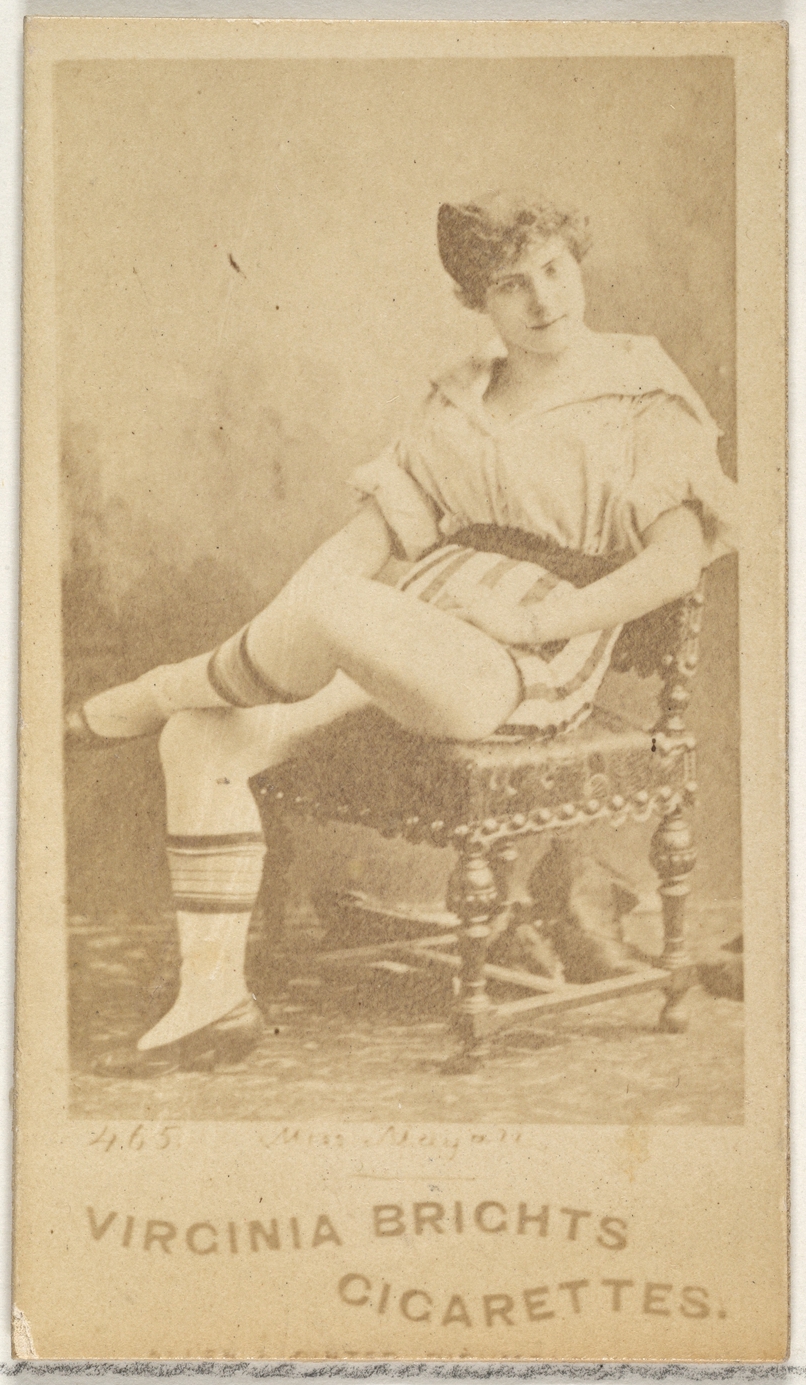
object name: photograph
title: Card 465, Miss Mayall, from the Actors and Actresses series (N45, Type 1) for Virginia Brights Cigarettes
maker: allen & ginter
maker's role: publisher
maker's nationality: american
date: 1888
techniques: albumen silver print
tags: portraits,women,actresses